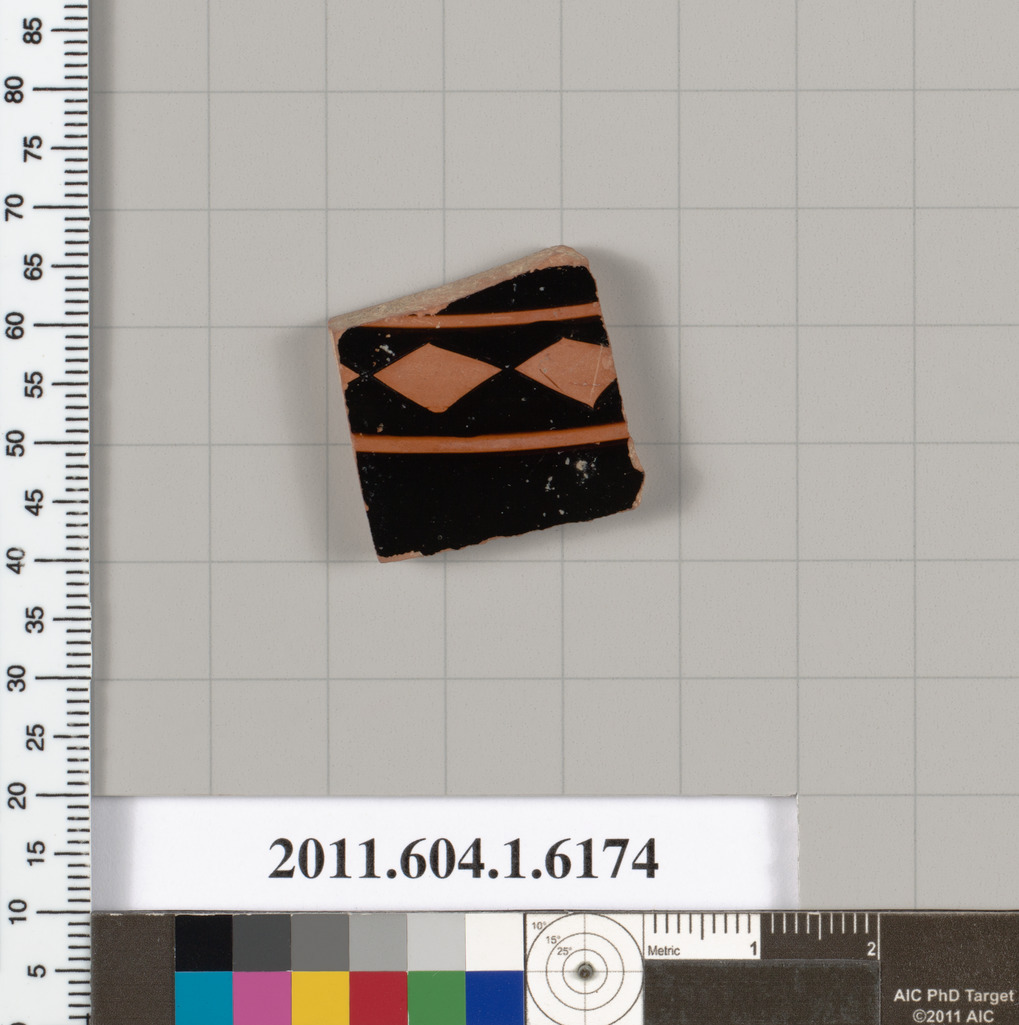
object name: kylix fragment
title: Terracotta fragment of a kylix (drinking cup)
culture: greek, attic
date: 520-500 BCE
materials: terracotta